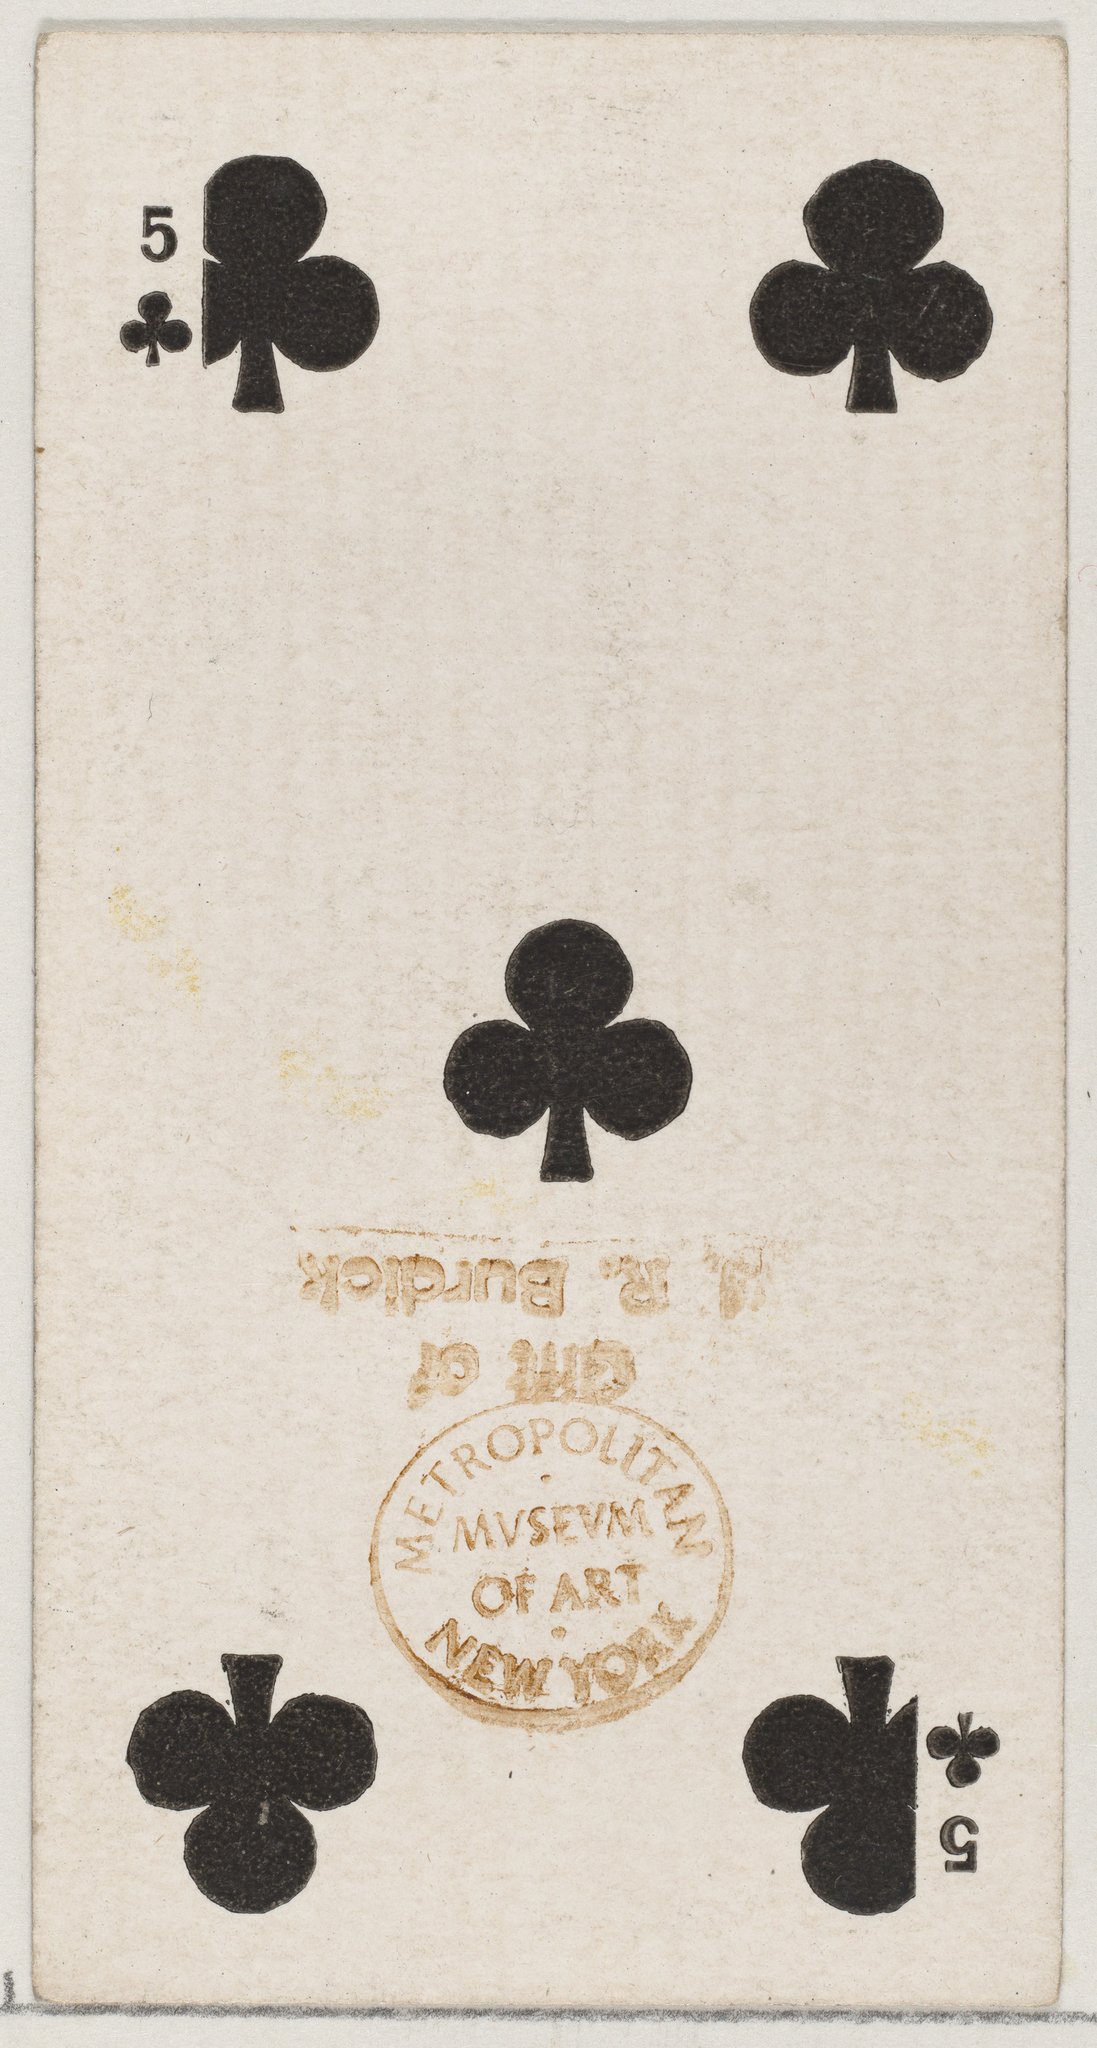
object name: print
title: Five Clubs (black), from the Playing Cards series (N84) for Duke brand cigarettes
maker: w. duke, sons & co.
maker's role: publisher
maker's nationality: american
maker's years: 1870-1920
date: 1888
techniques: color lithograph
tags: playing cards